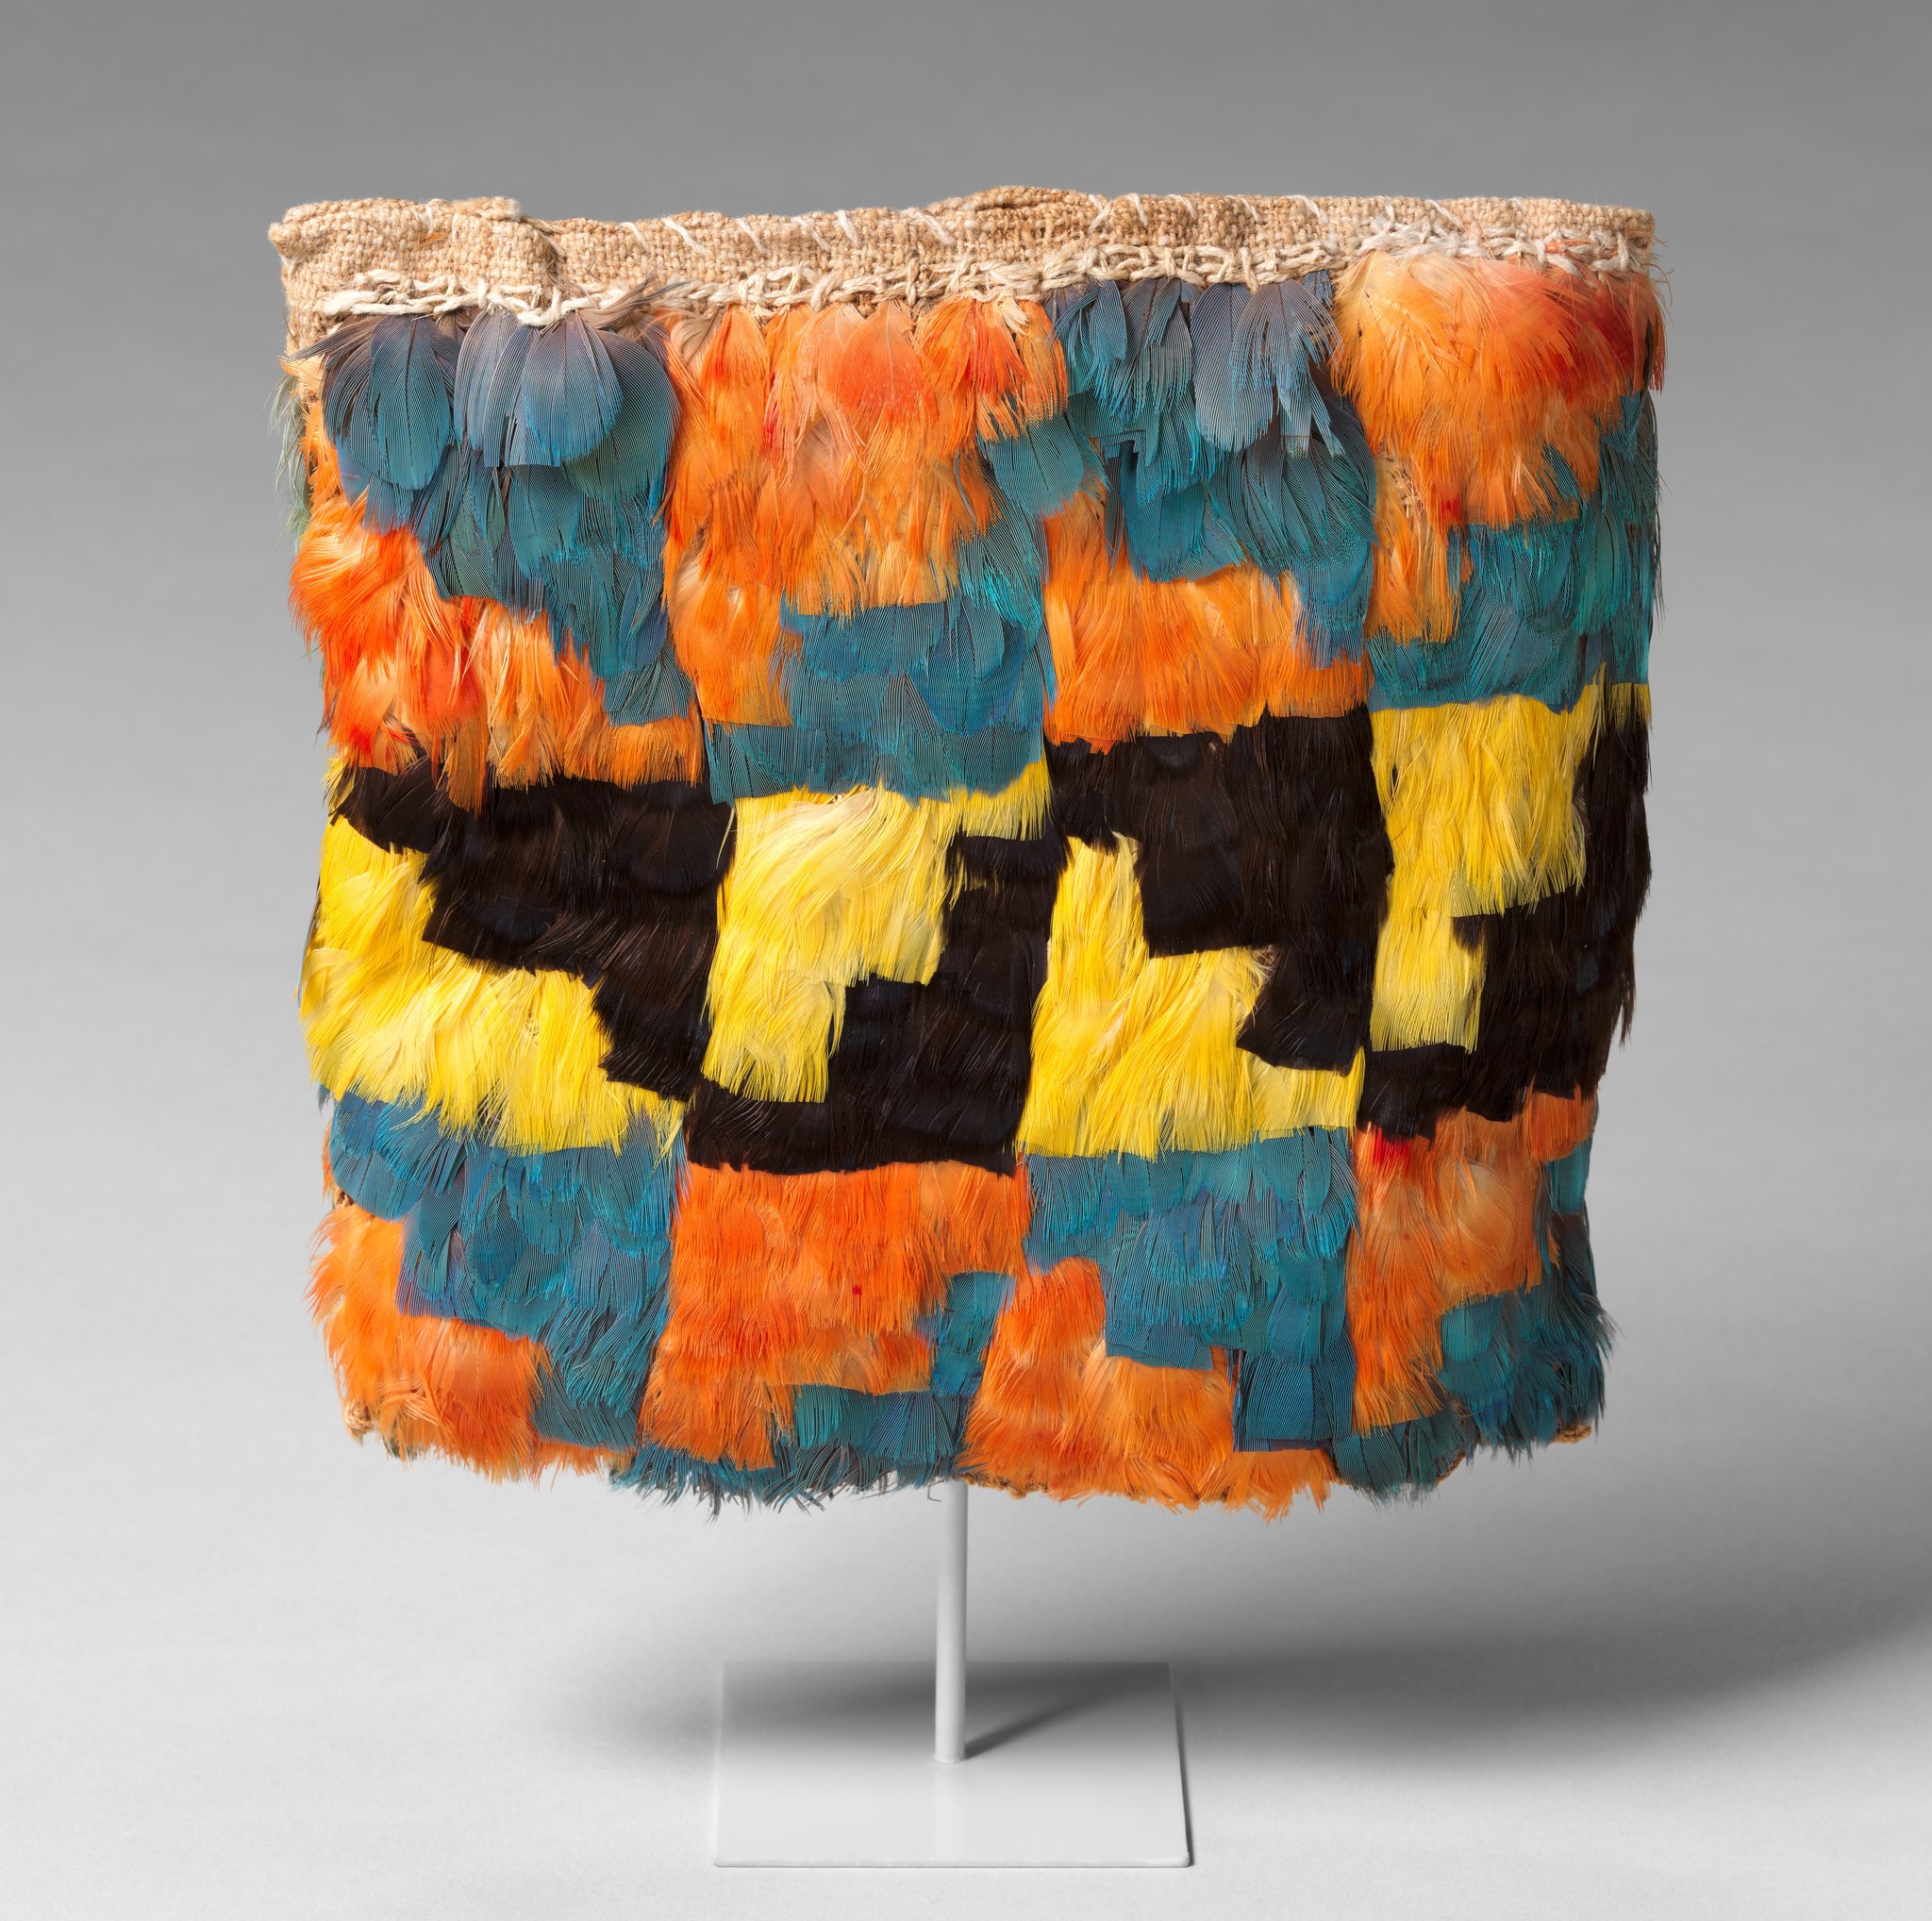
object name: miniature dress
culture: ica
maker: ica artist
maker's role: artist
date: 1101-1300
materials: cotton, feather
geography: peru